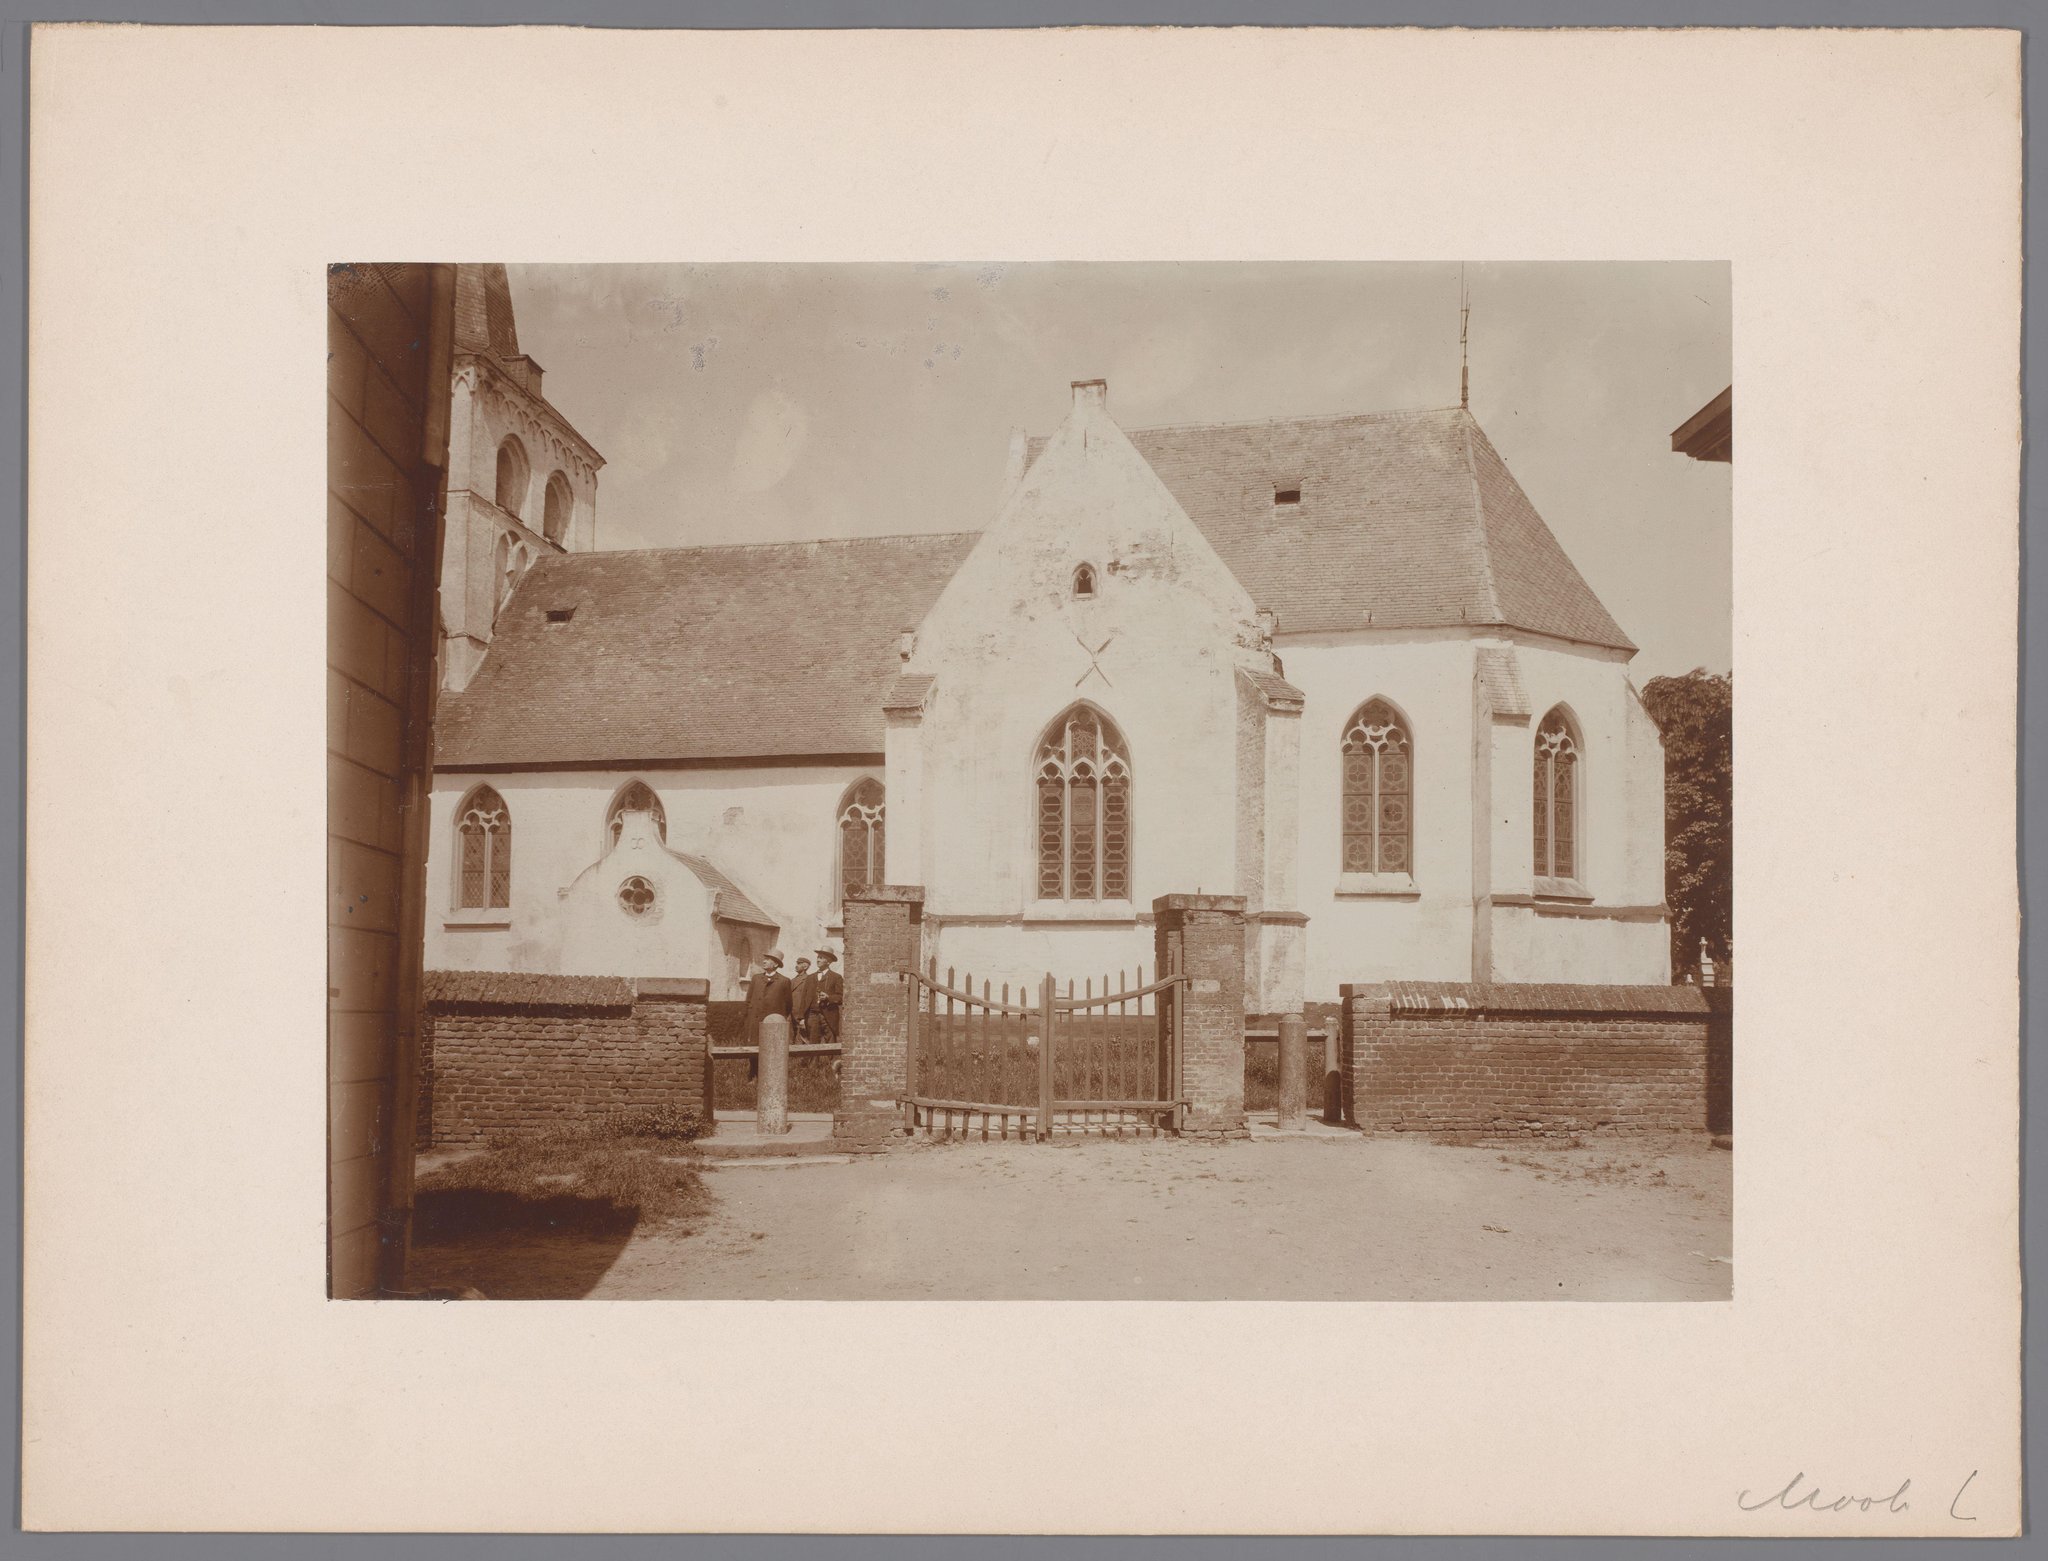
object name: photograph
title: Gezicht op de Sint-Antonius Abtkerk te Mook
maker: anoniem (monumentenzorg)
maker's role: fotograaf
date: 1906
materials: cardboard, photographic support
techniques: collodion silver print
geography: mook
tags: church (exterior)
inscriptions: annotation: ‘Mook L’, annotation: ‘R.K. Kerk te Mook (L.)/ juni 1906’